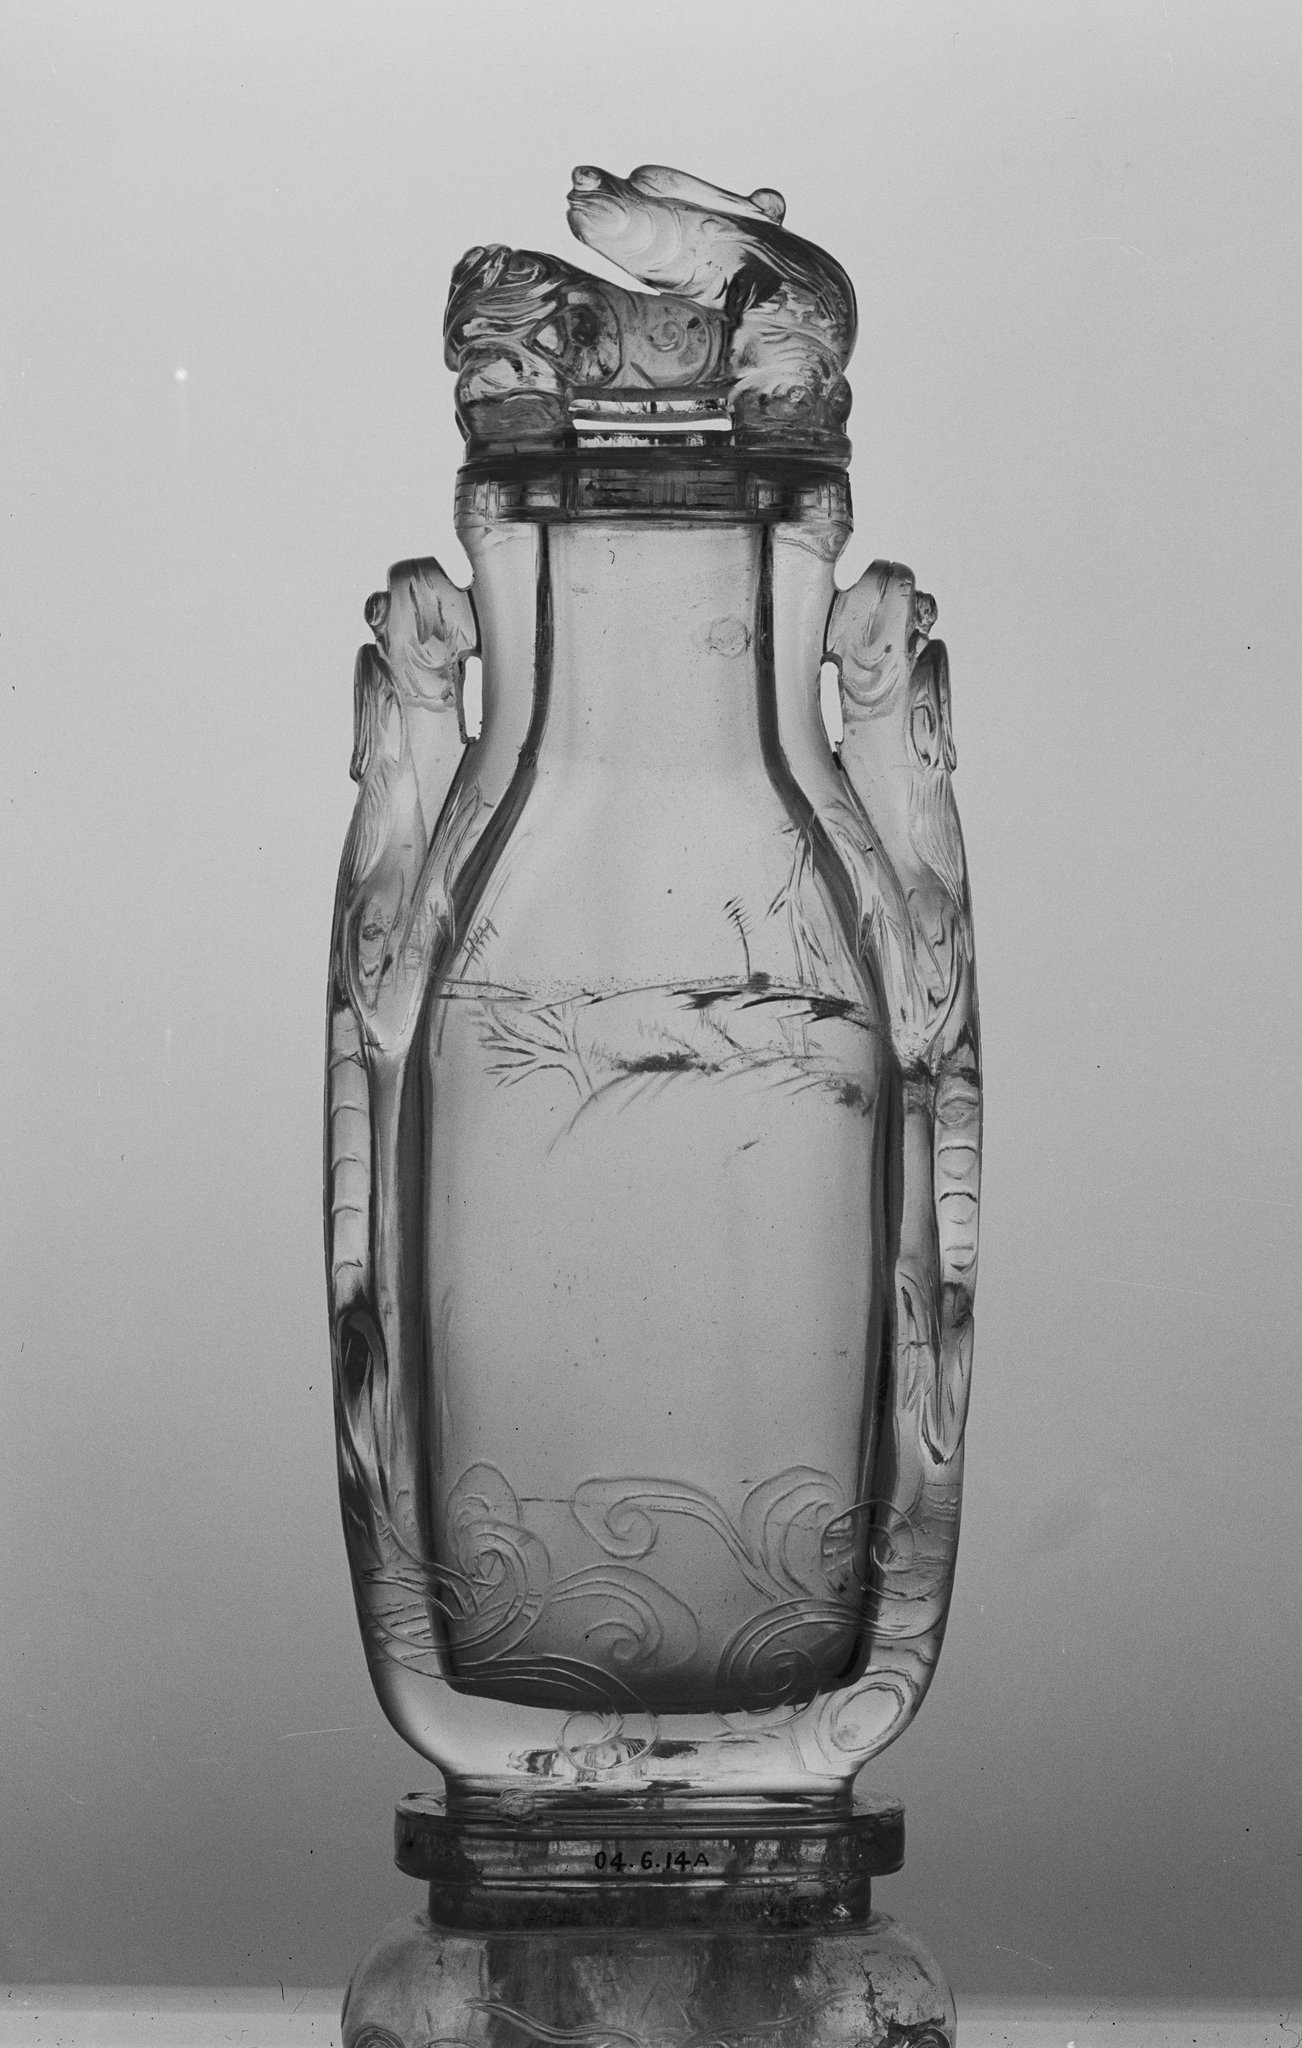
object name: flask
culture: chinese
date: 1801-1900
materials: quartz